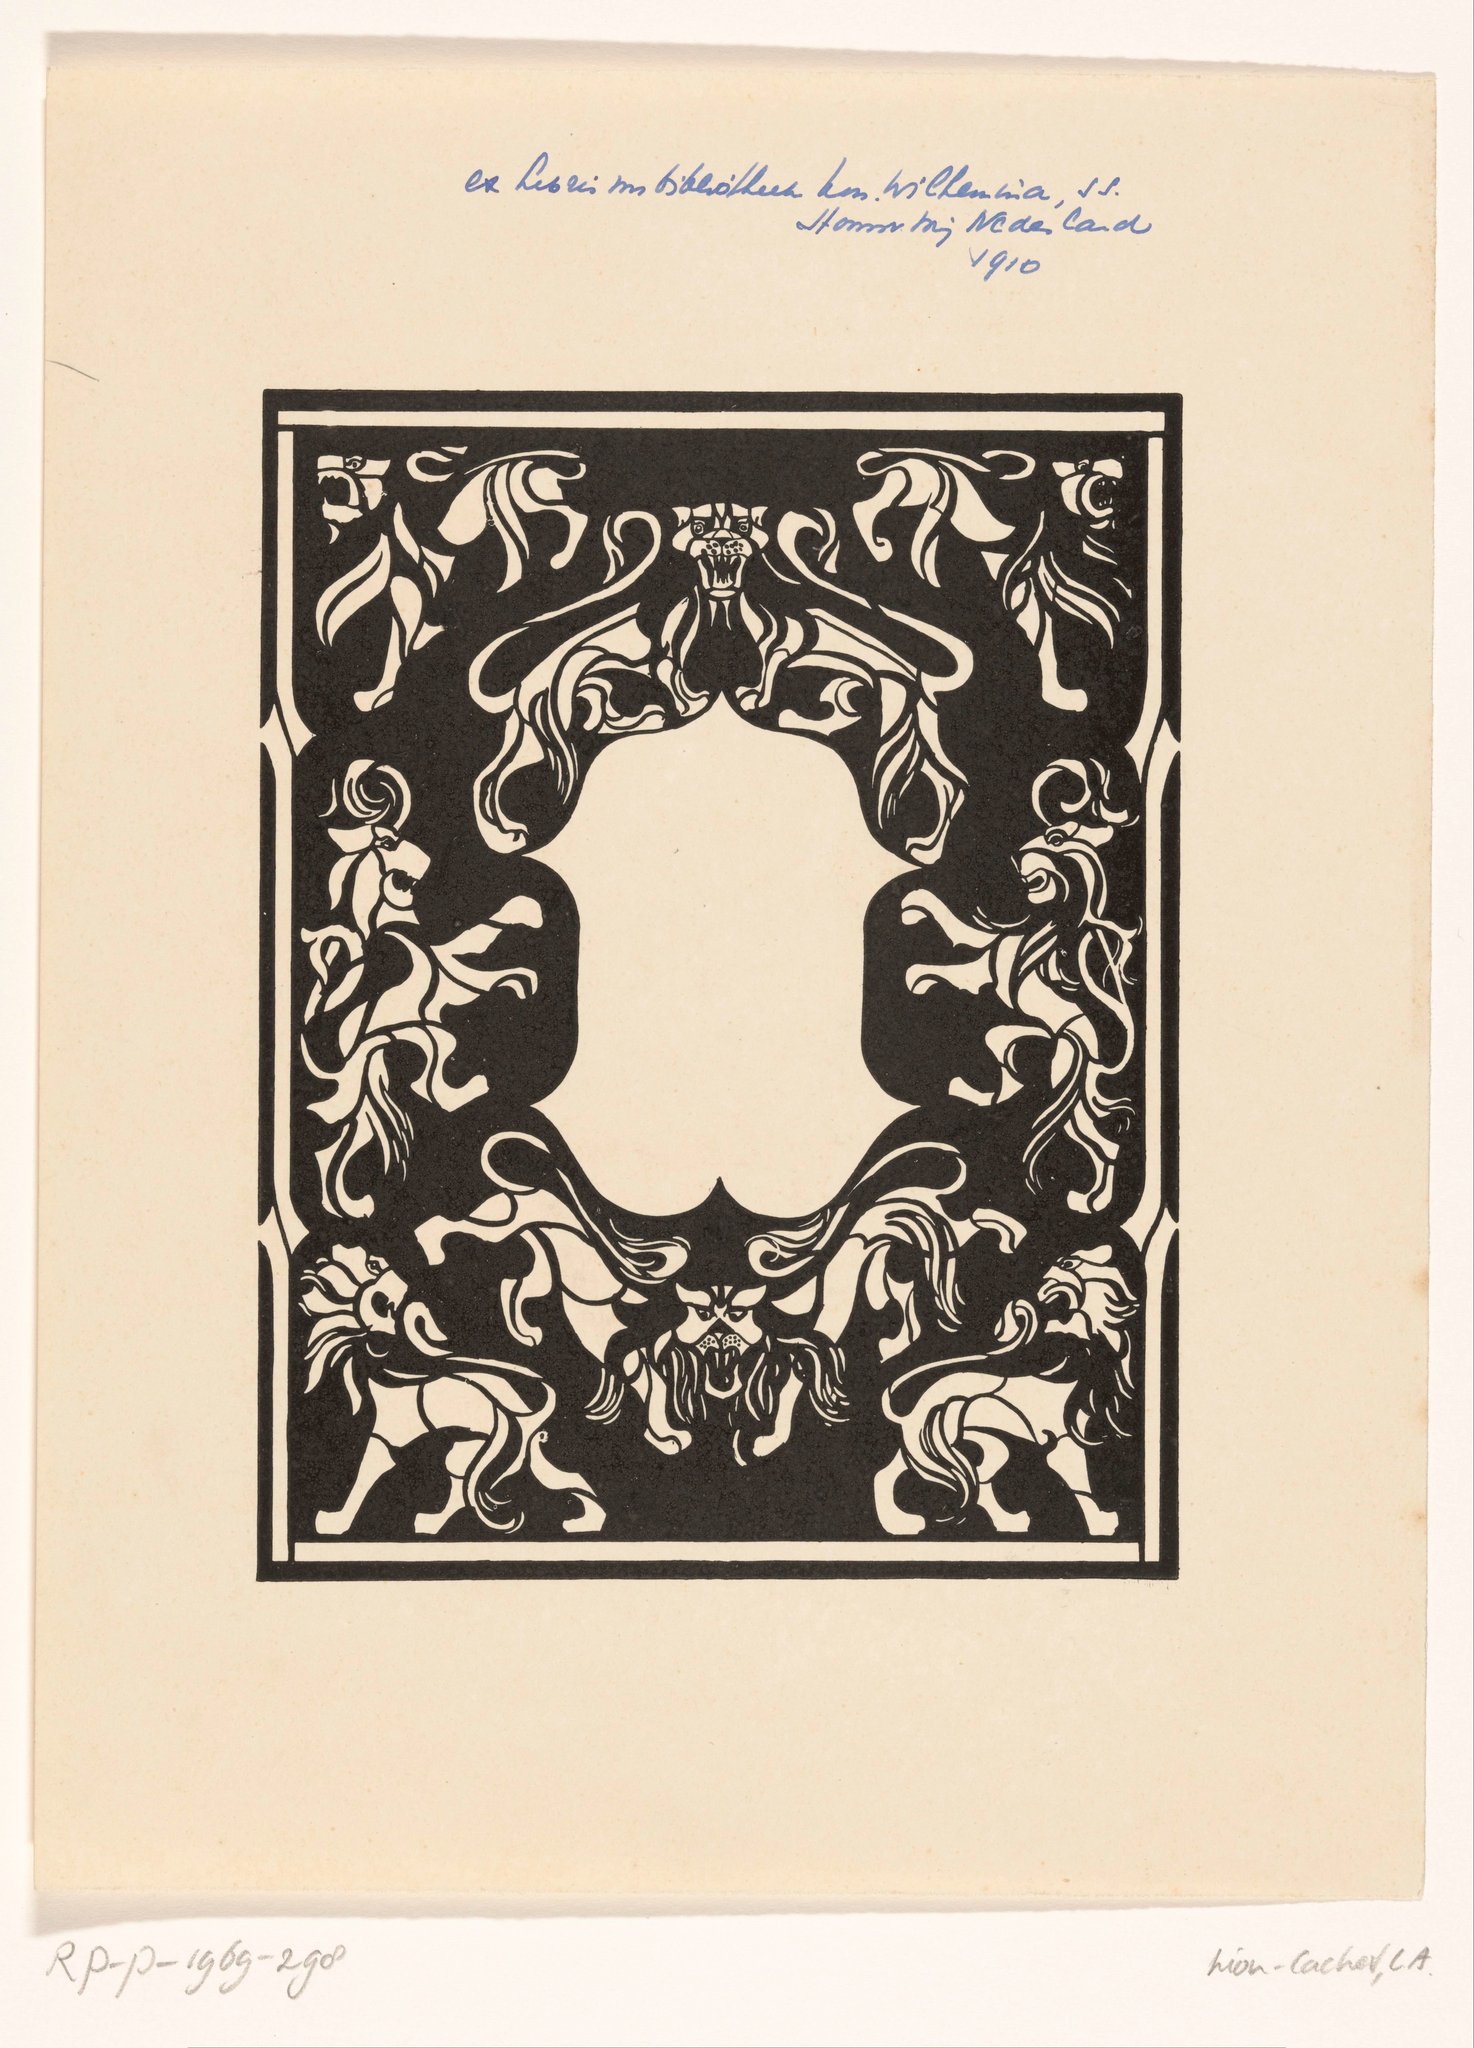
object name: print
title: Ex libris van het stoomschip Koningin Wilhelmina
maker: carel adolph lion cachet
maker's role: draughtsman, print maker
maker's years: 1864-1945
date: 1910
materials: paper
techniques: printing block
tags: beasts of prey, predatory animals: lion, steamship, motorship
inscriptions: collector's mark: Lugt 2228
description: Tien leeuwen in een kader met in het midden een uitsparing.